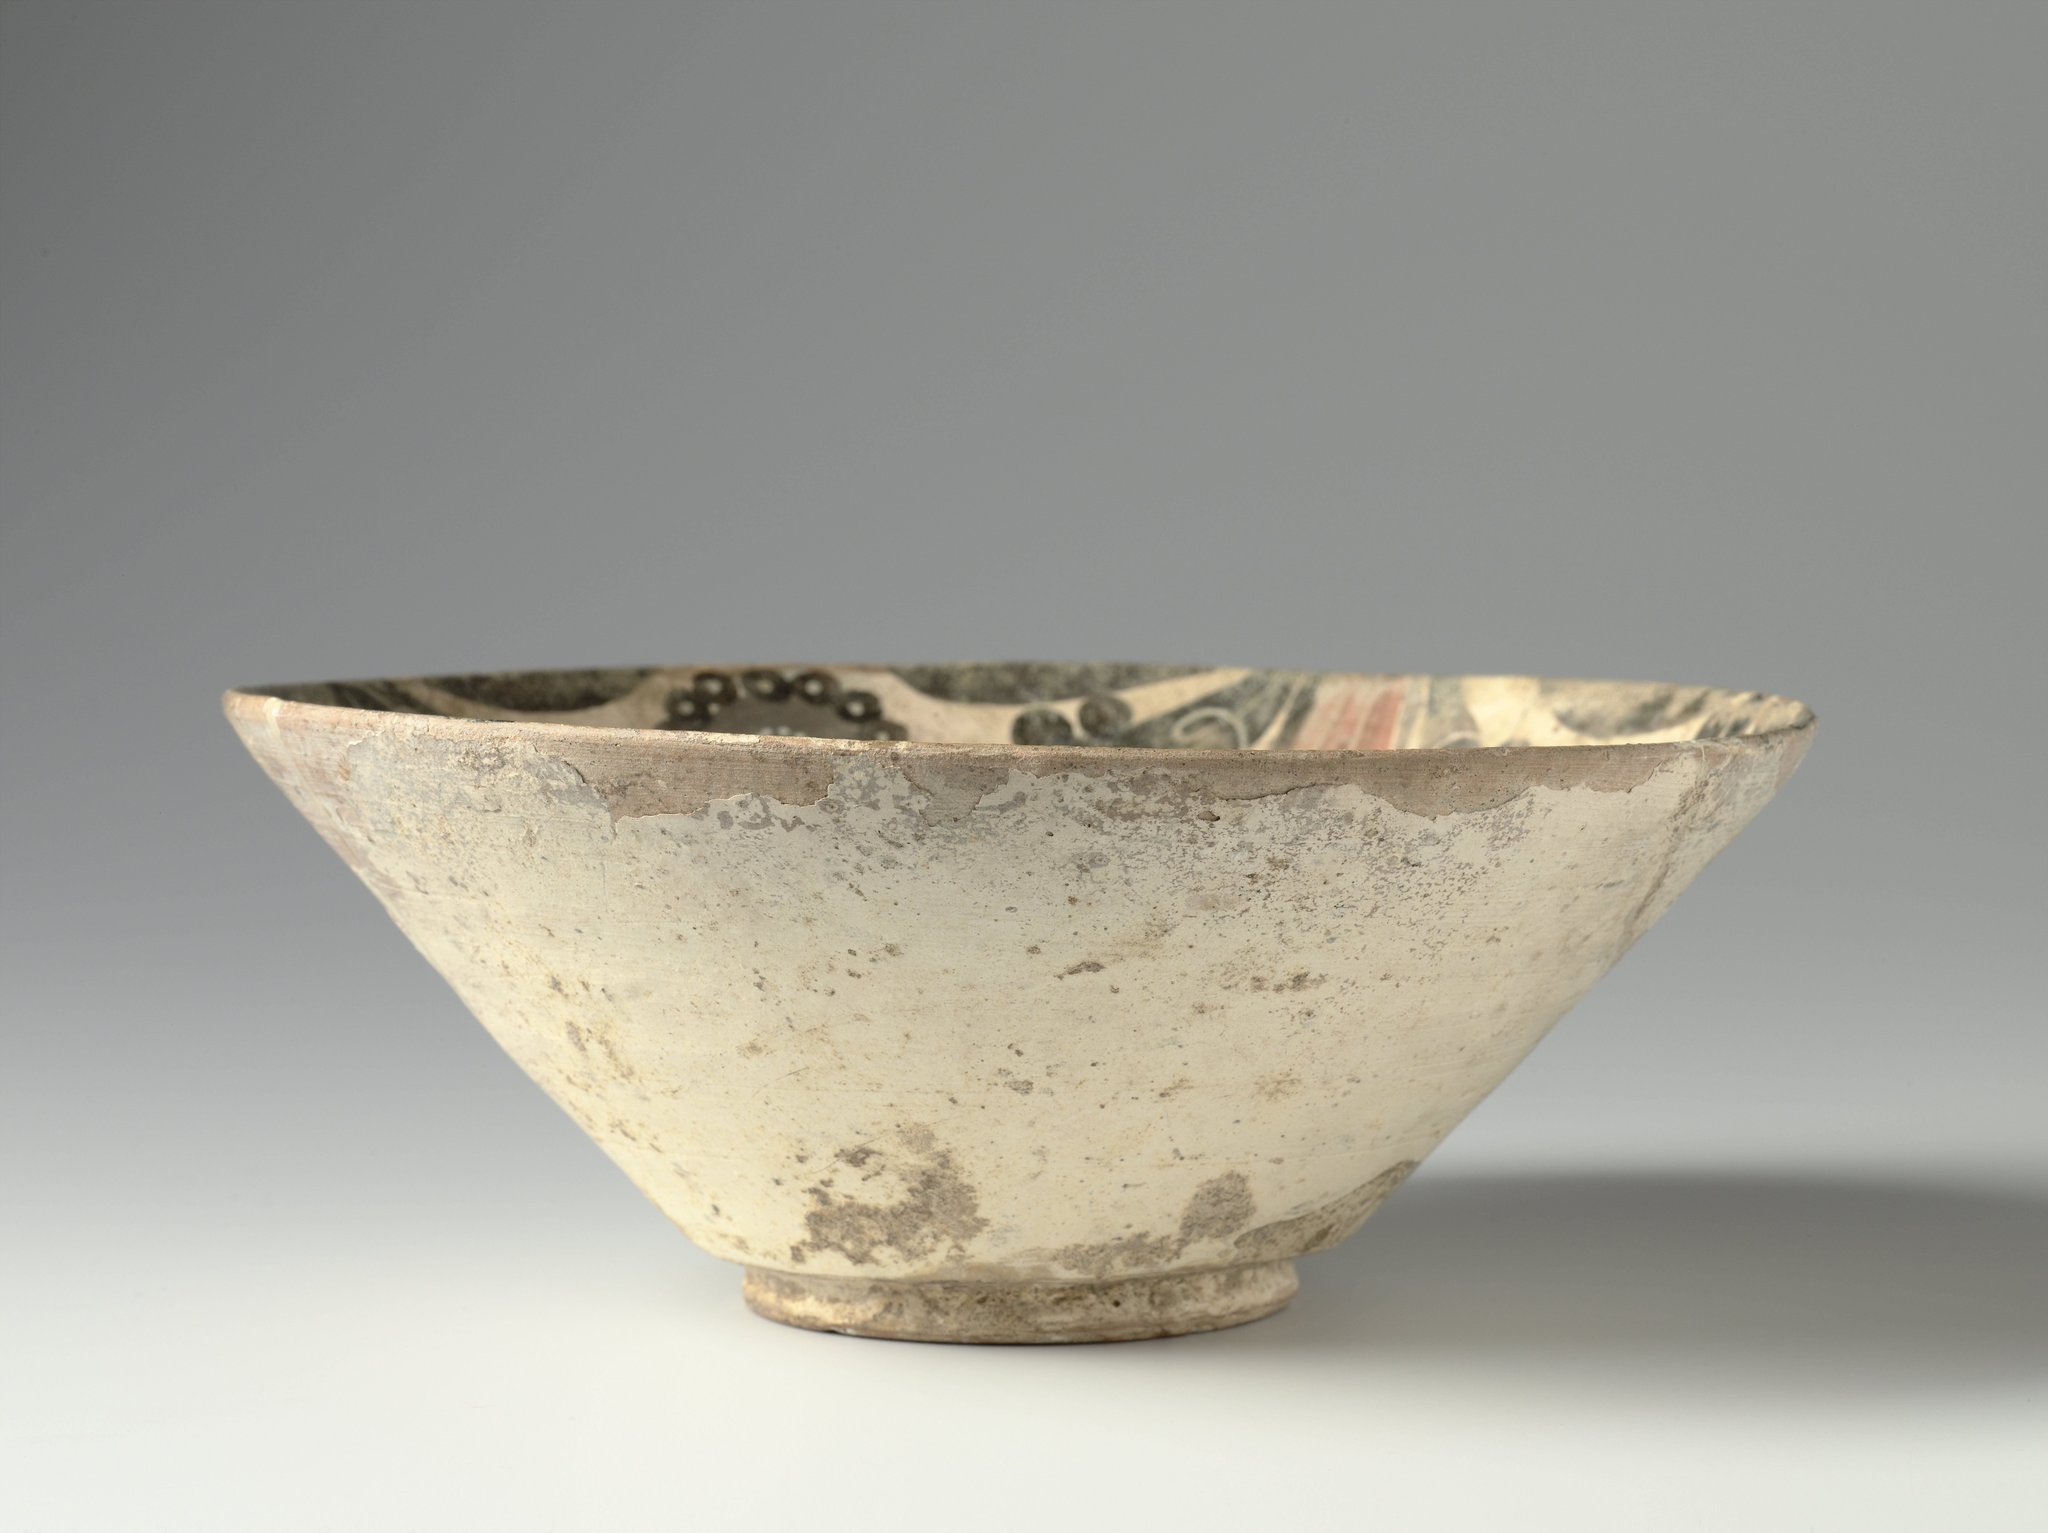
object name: bowl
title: Bowl with stylized flower sprays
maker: Anonymous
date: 900-999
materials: earthenware, glaze, paint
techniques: firing, turning, vitrification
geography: sari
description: Kom van aardewerk gedecoreerd met zwarte, rode, grijze en witte slib, met enkele incisies door de kleuren heen, op een engobe van witte slib. Op de binnenzijde gestileerde bloemtakken.